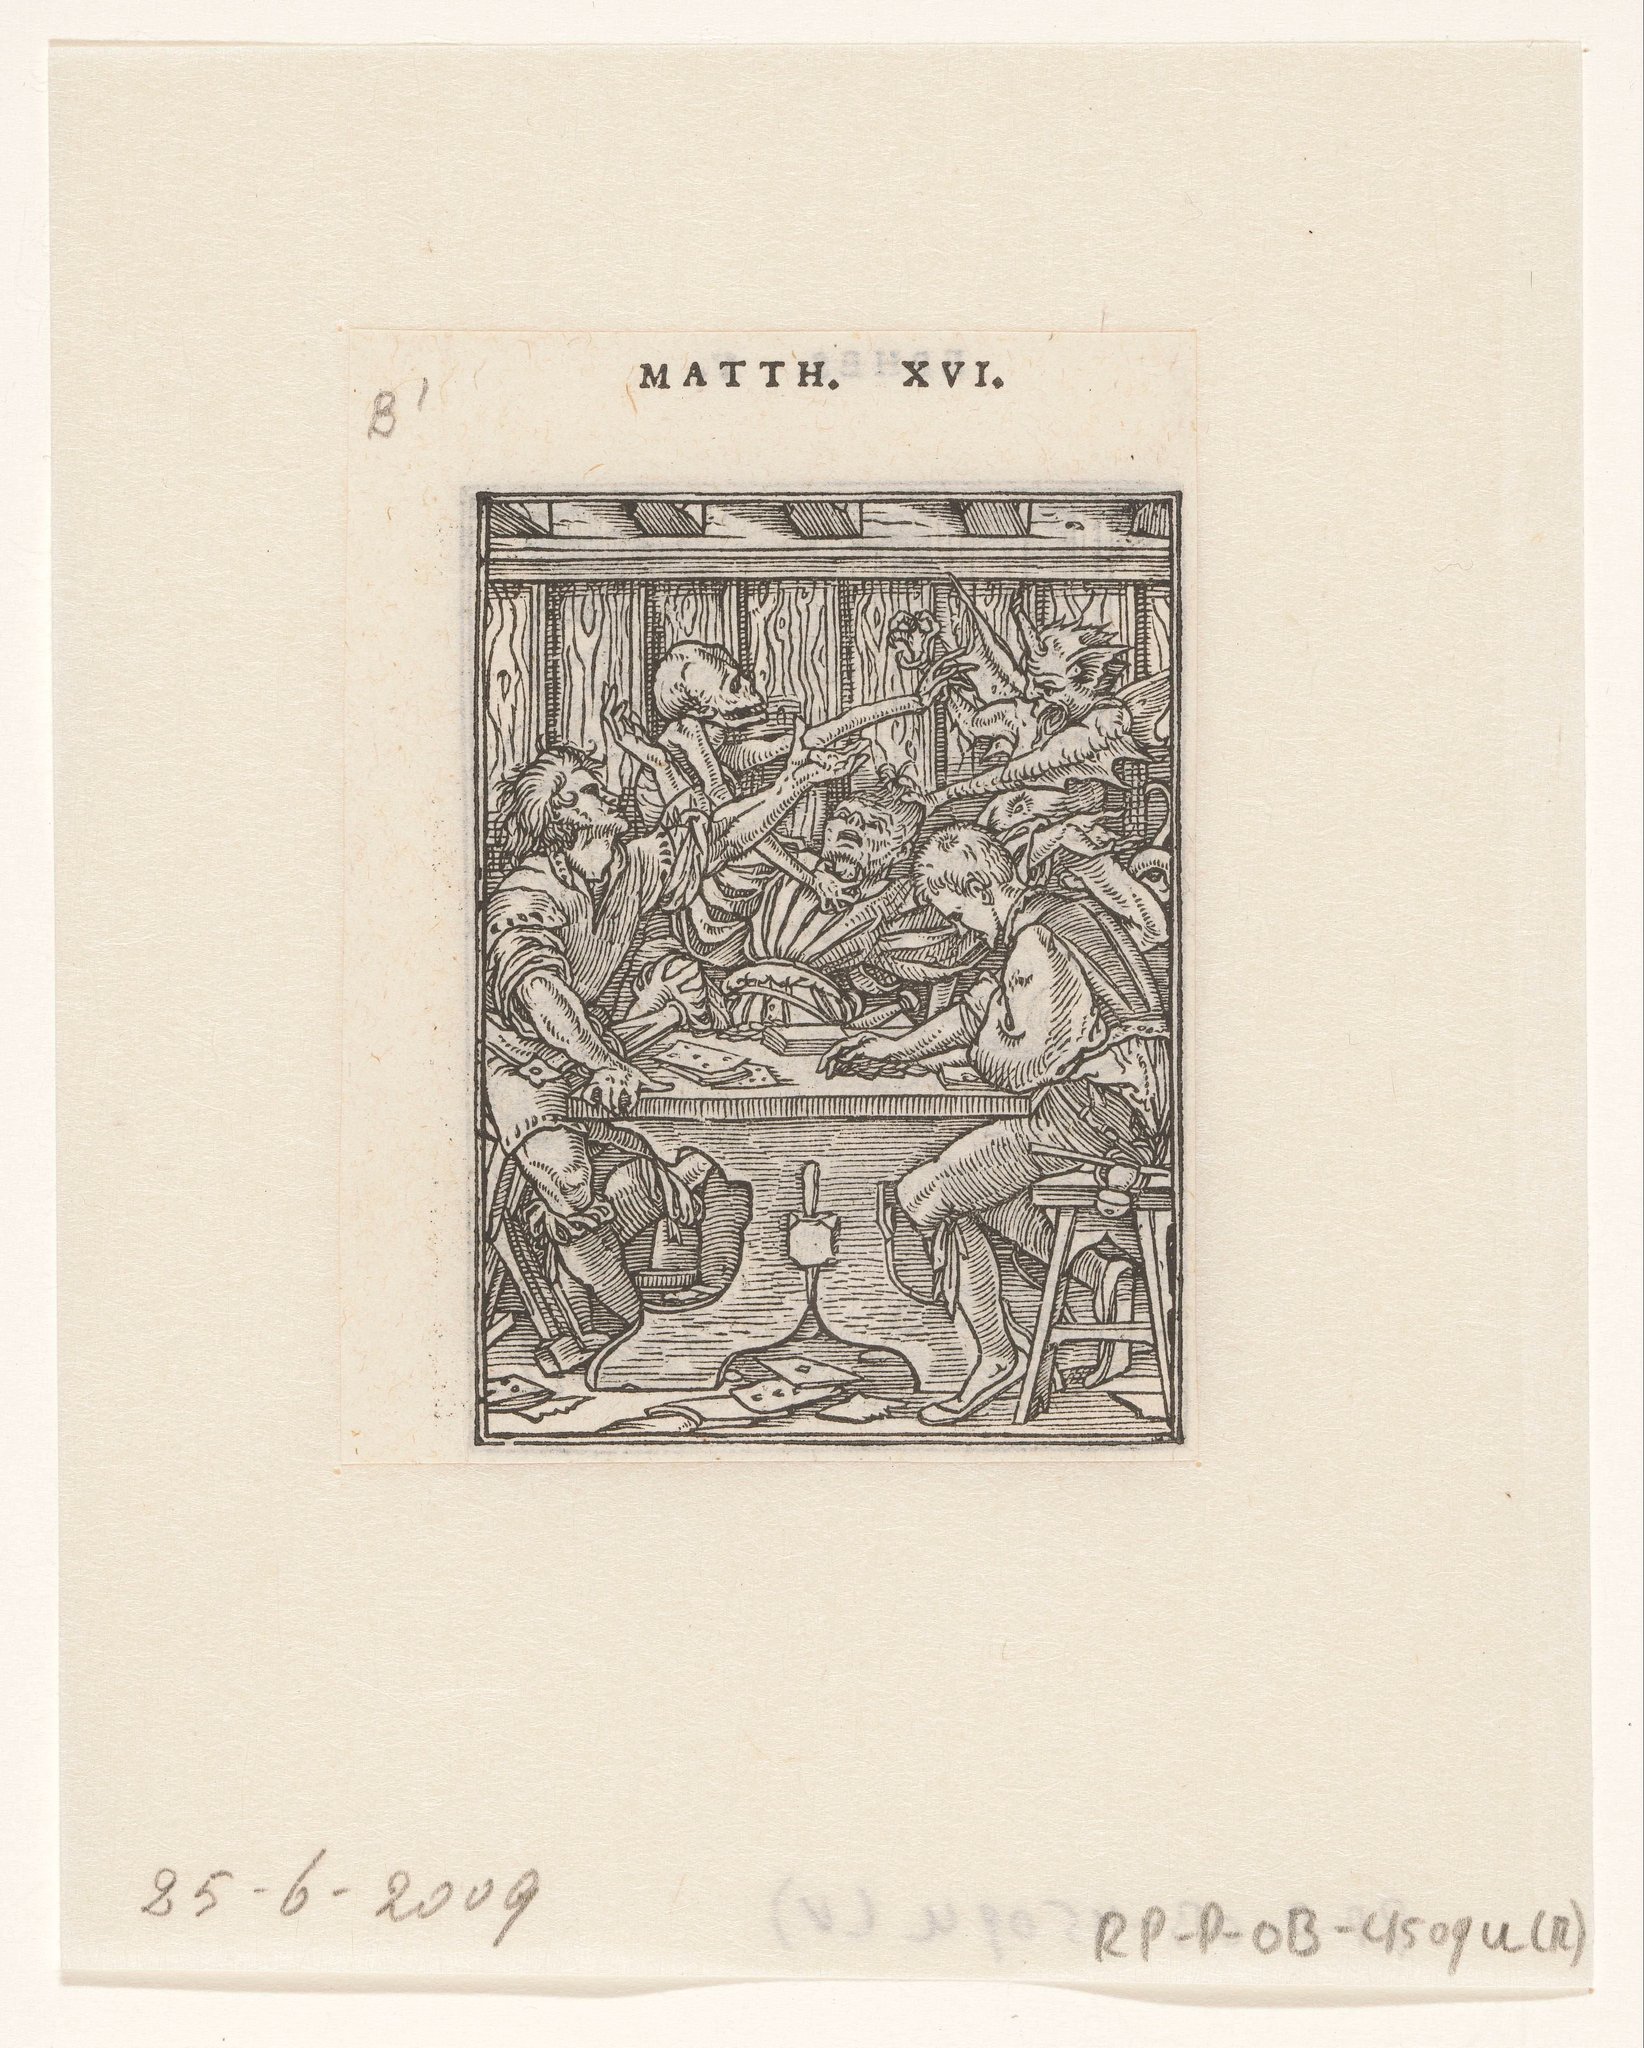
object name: print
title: Dodendans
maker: hans holbein (der jüngere)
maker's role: draughtsman, painter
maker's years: 1497-1543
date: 1547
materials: paper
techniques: woodcut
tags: dance of death; death together with one or more human beings, card games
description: De serie boekillustraties bekend onder de titel Dodendans werden in 1547 aangevuld met twaalf houtsneden die voor het eerst verschenen in: Imagines Mortis duodecim Imaginibus praeter priores ... à Georgio Aemylio translata, cumulatae ..., Lyon 1547, J. en F. Frellon. Later verschenen nog andere uitgaven.